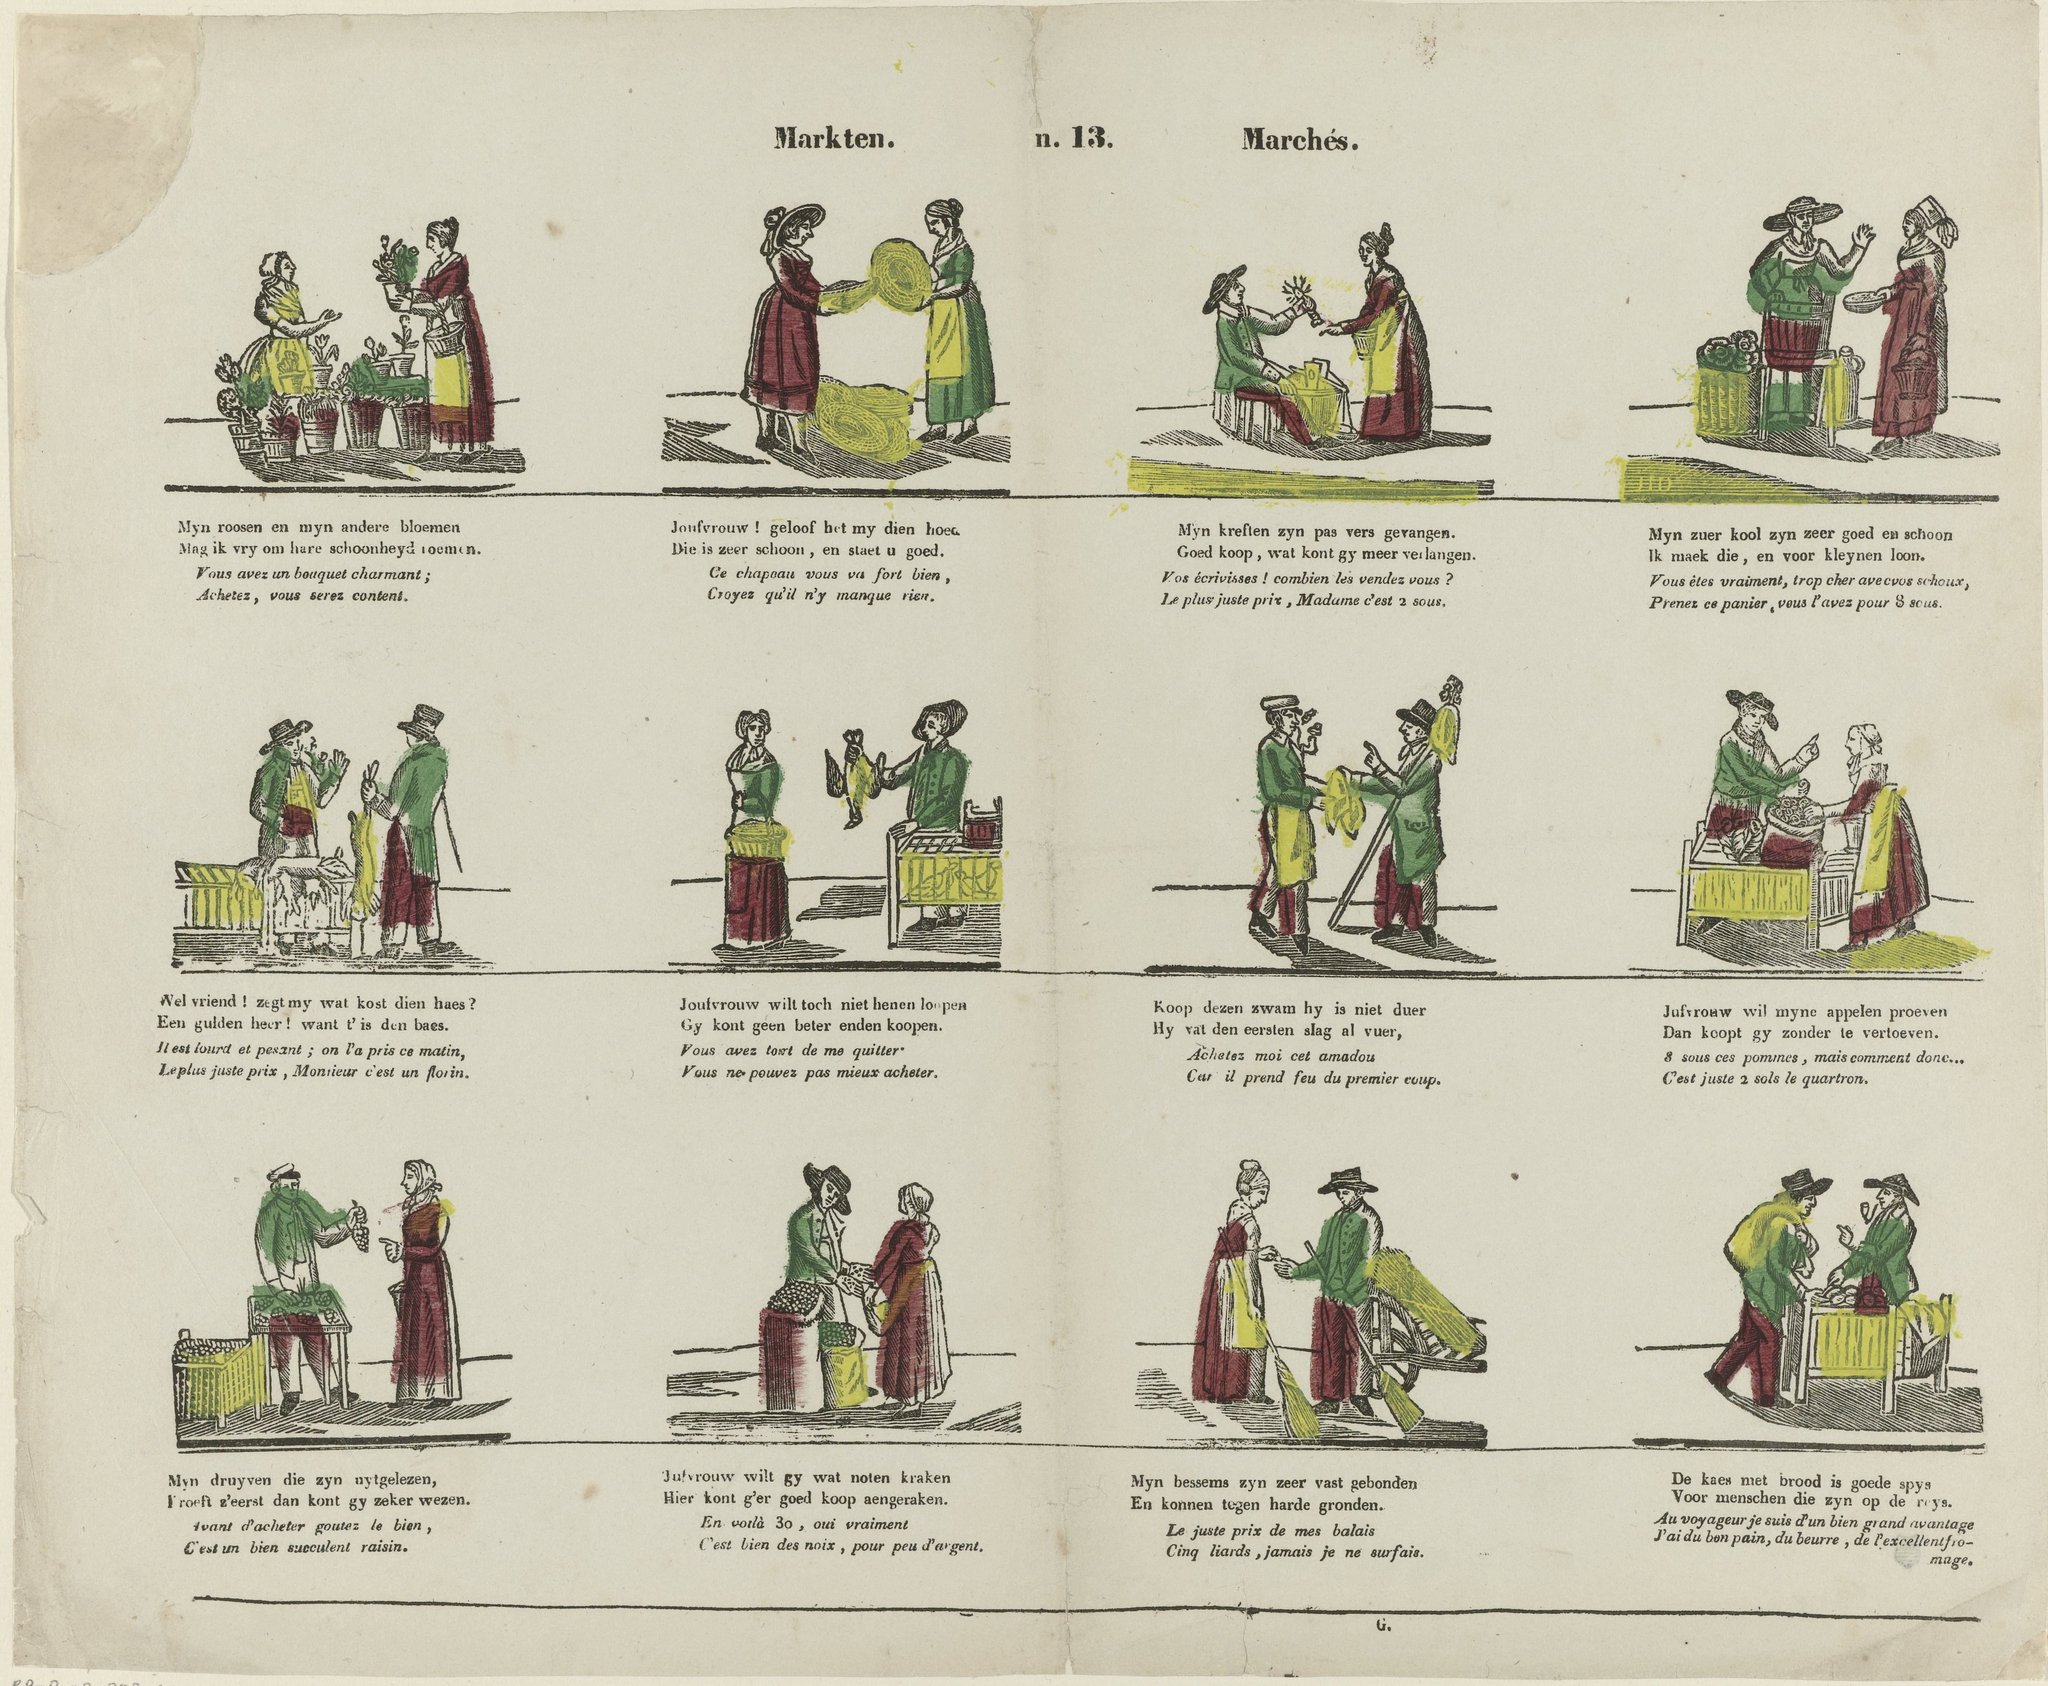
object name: popular print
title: Markten / Marchés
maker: Anonymous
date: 1833-1856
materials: paper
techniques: colour, letterpress printing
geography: turnhout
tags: street-trader, merchant, salesman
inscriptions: collector's mark: Lugt 2760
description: Blad met 12 voorstellingen van straatverkopers, zoals een bloemenverkoopster, een eendenverkoper en een bezemverkoper. Onder elke afbeelding een tweeregelig vers in het Nederlands en in het Frans. Genummerd midden boven: n. 13.